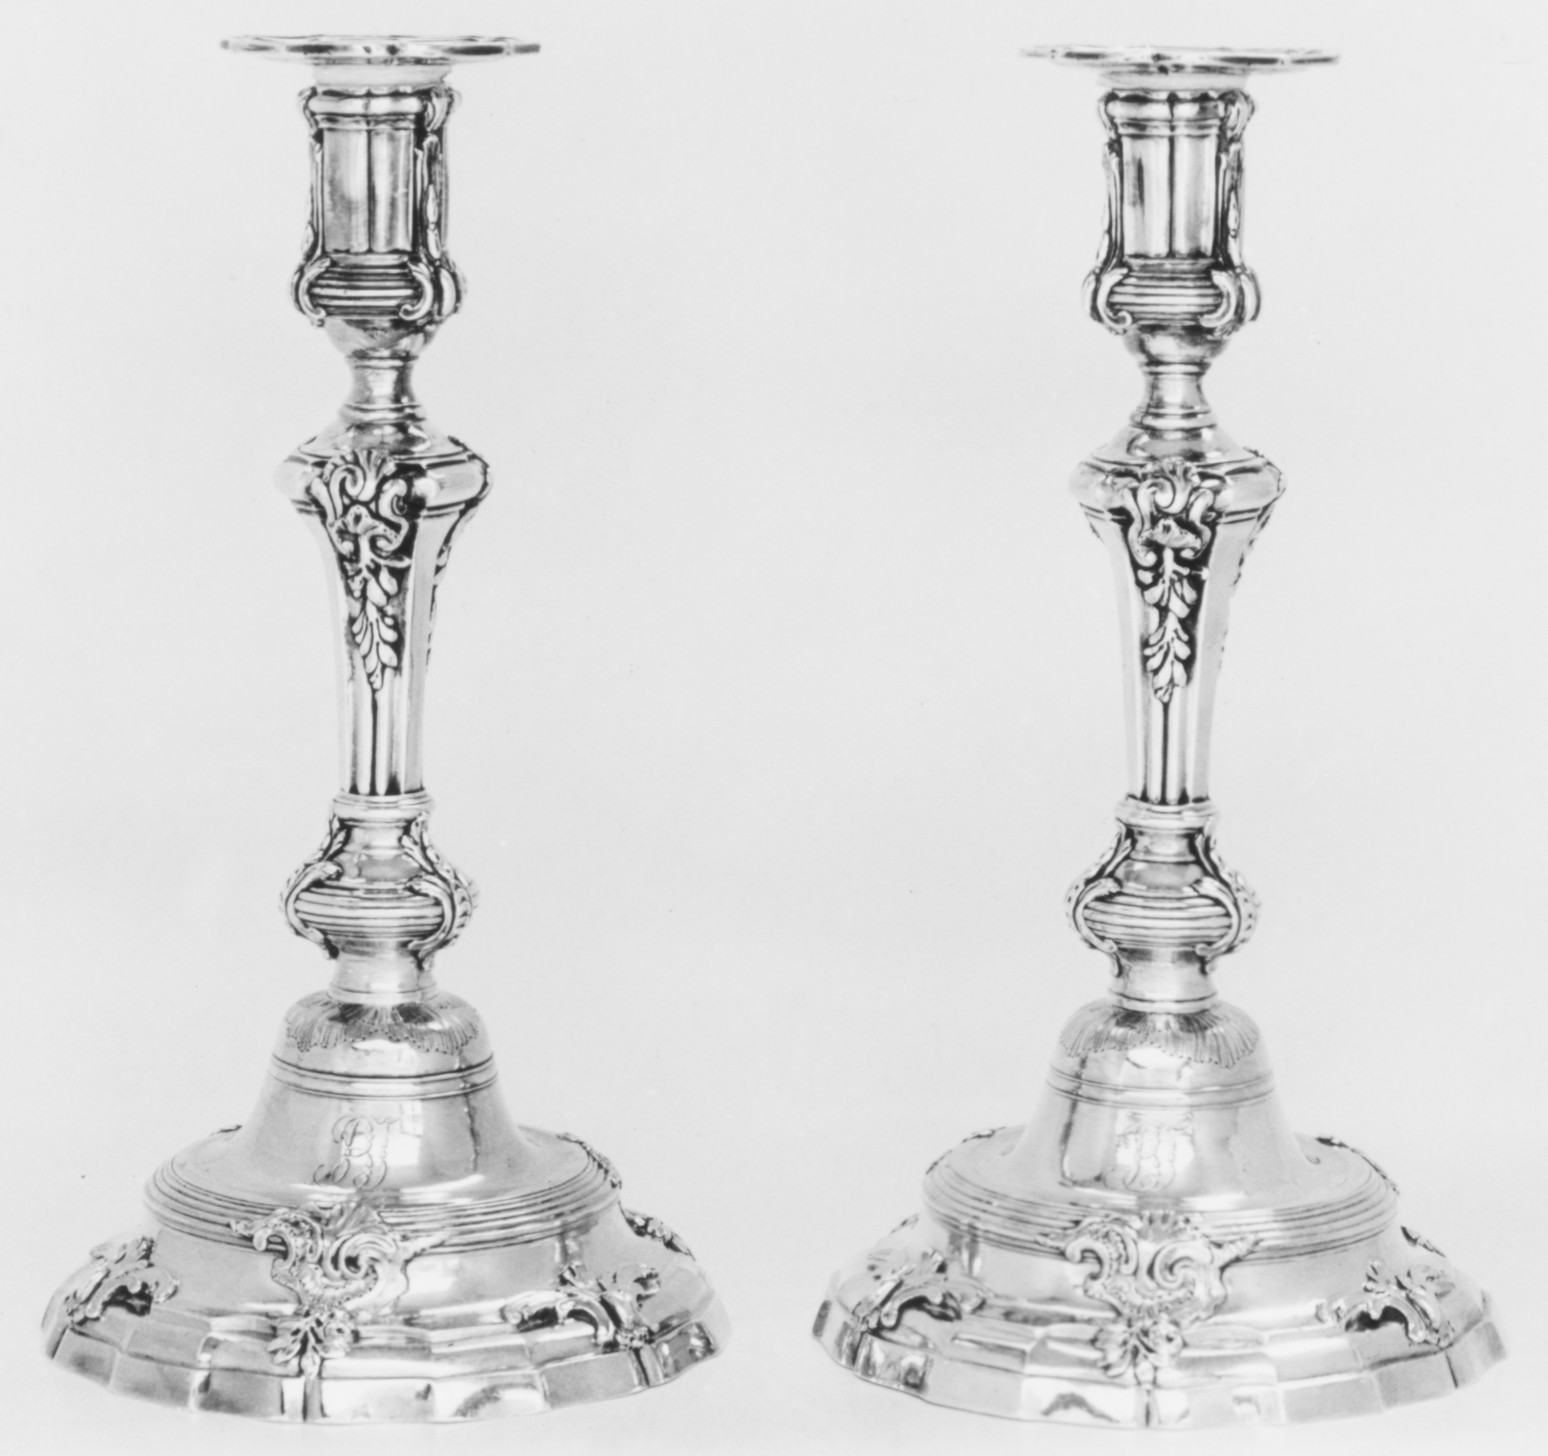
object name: candlestick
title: Pair of candlesticks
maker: michel ii delapierre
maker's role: maker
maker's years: 1707-1815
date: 1756-1757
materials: silver